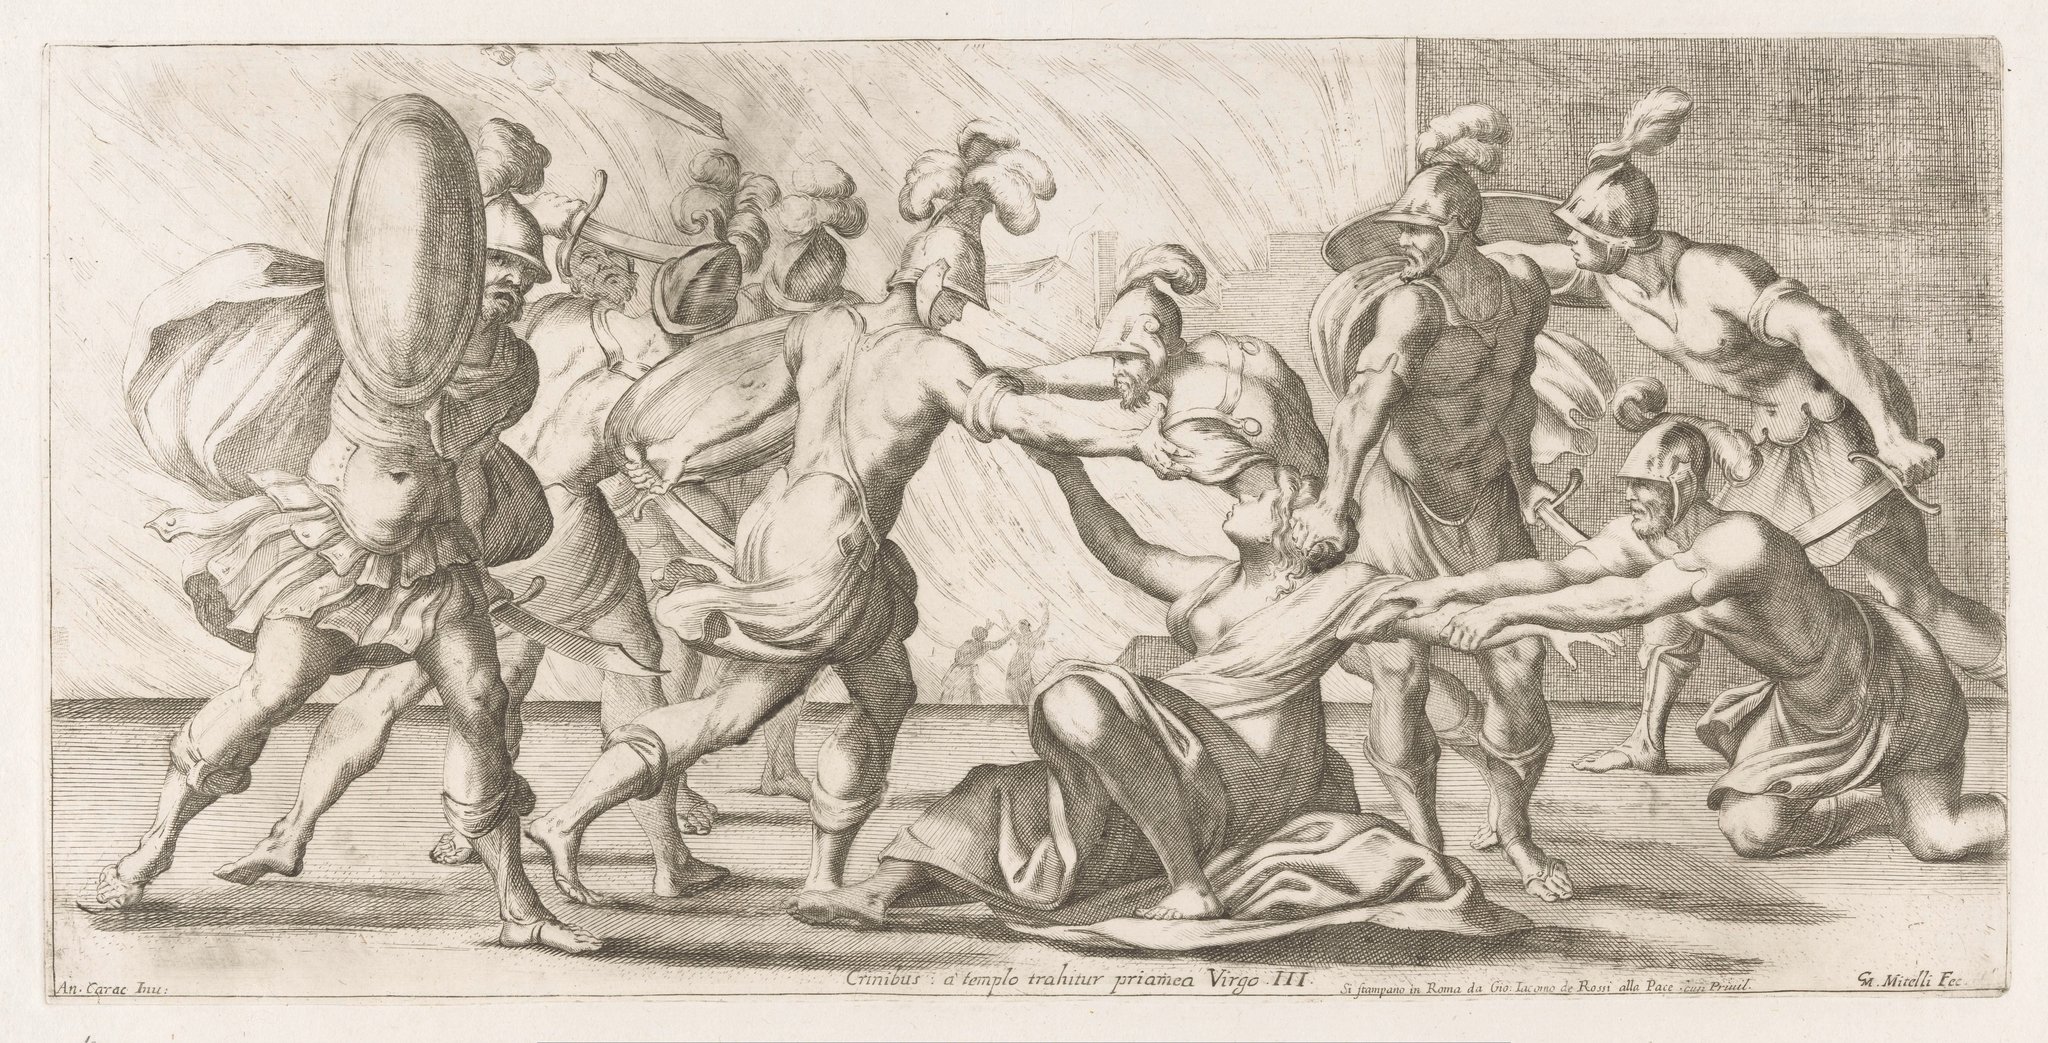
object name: print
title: Crinibus : à templo trahitur priamea Virgo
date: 1663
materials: paper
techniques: etching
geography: italy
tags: (story of) cassandra, cassandra, sheltering in minerva's temple (sometimes with andromache), is dragged away by ajax the lesser, while she holds the image of the goddess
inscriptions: collector's mark: Lugt 2228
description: Deze prent maakt deel uit van een reeks van 20 prenten (+ titelprent) naar de fresco's door de Carracci's in Palazzo Fava Ghisilieri te Bologna.